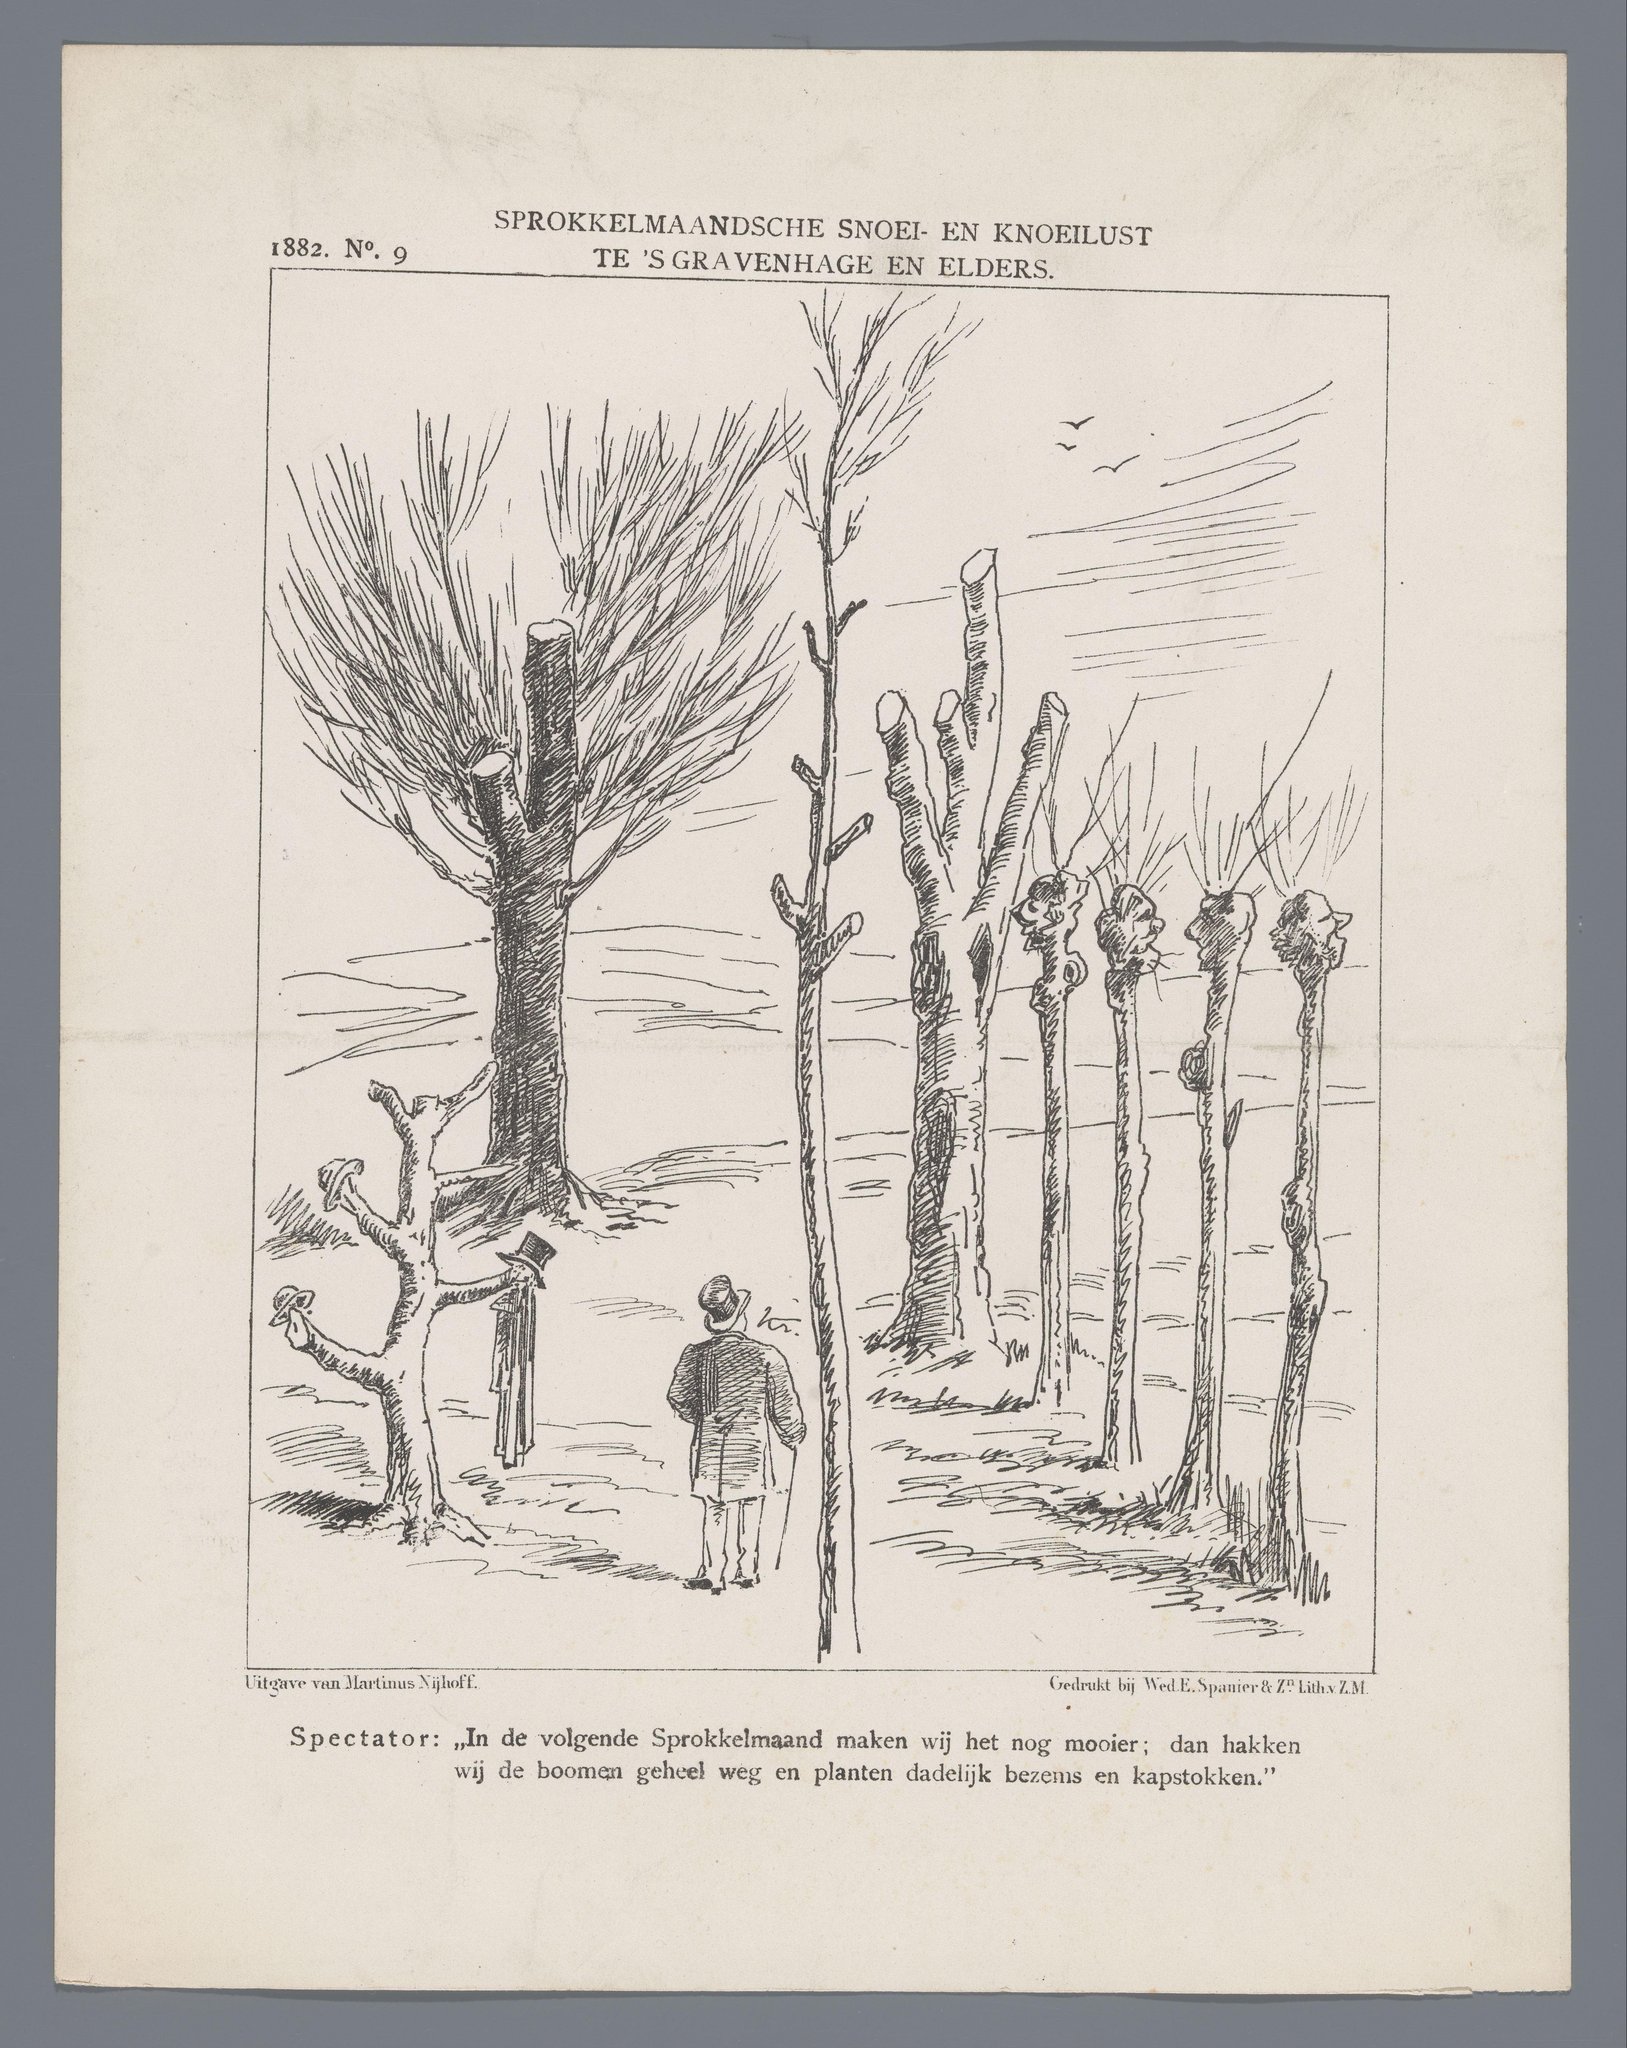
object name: print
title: Sprokkelmaandsche snoei- en knoeilust te 's Gravenhage en elders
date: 1882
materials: paper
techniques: lithograph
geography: netherlands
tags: the hague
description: Politieke spotprent over Den Haag: gesnoeide knotwilgen. Plaat verschenen bij het weekblad De Nederlandsche Spectator, nr. 9, 1882.